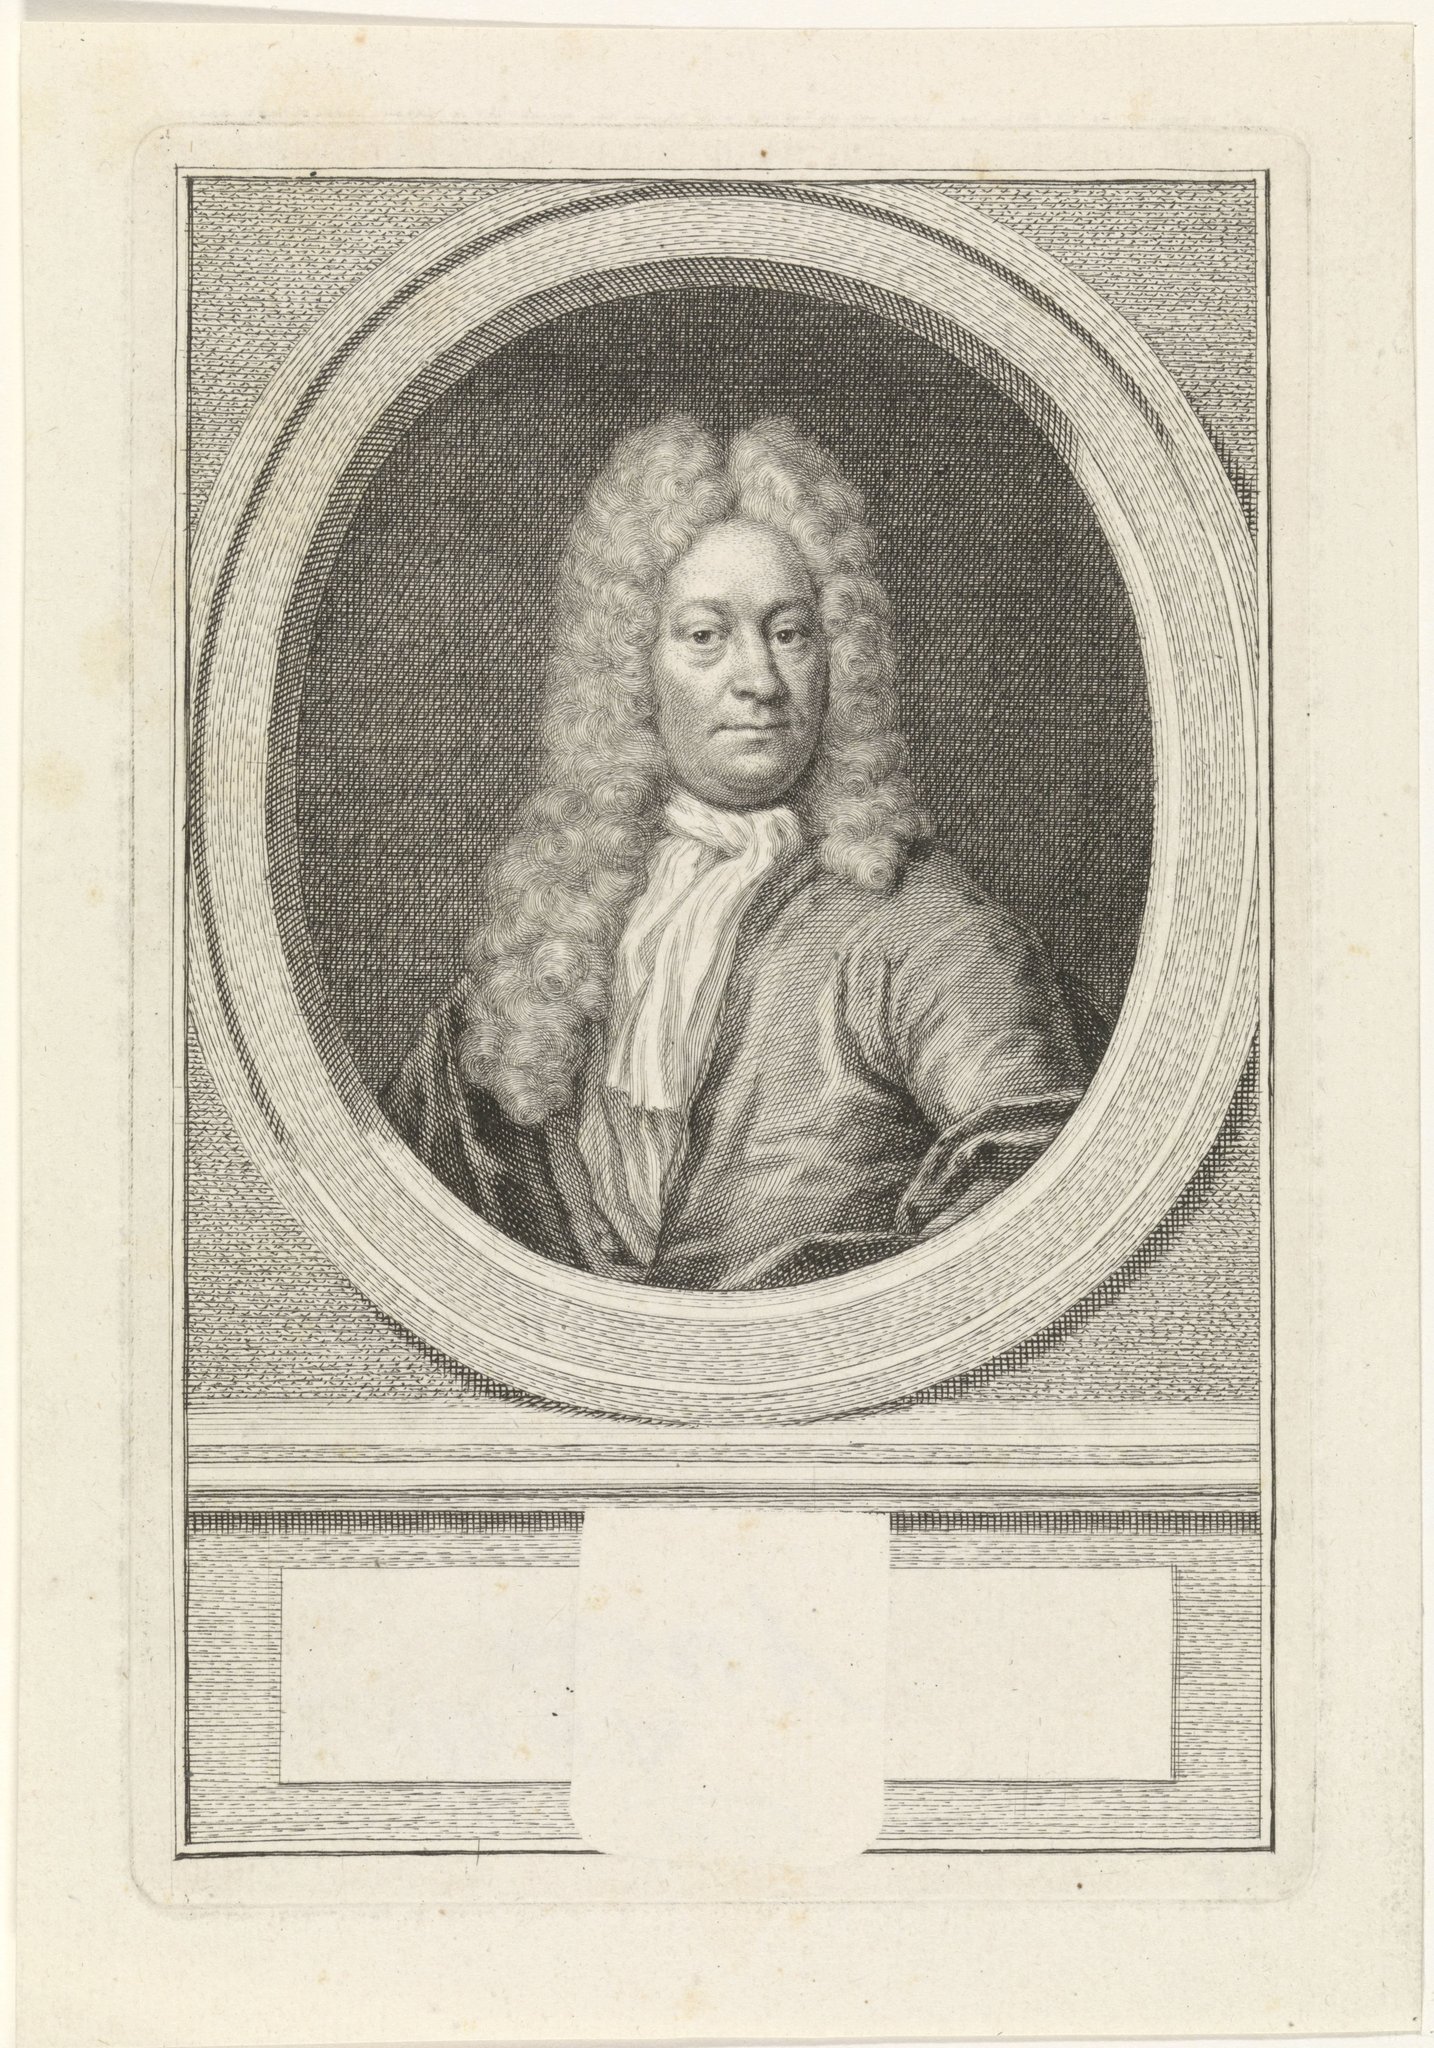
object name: print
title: Portret van Jan Sautijn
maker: jacob houbraken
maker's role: draughtsman, print maker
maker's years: 1698-1780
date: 1749-1780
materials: paper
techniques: engraving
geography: amsterdam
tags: mayor, historical persons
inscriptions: collector's mark: Lugt 2228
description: Latere staat van deze prent is oorspronkelijk bedoeld als aanvulling op Jan Wagenaars ‘Vaderlandsche historie’* en was zo vanaf 1796 verkrijgbaar bij Johannes Allart te Amsterdam. Voor de advertentie waarin Allart de 60 portretten en 7 platen, allen gegraveerd door Houbraken, ter aanvulling op Wagenaars ‘Vaderlandsche historie’ aanbiedt, zie RP-P-OB-77.766. *Van dit werk zijn in de achttiende eeuw meerdere uitgaves verschenen, zoals: Wagenaar, Jan. Vaderlandsche historie, vervattende de geschiedenissen der Vereenigde Nederlanden (…). 21 delen. Amsterdam: Isaak Tirion, 1749-1759. Wagenaar, Jan. Vaderlandsche historie, vervattende de geschiedenissen der nu Vereenigde Nederlanden (…). 21 delen. Amsterdam: weduwe Isaak Tirion, 1770. Wagenaar, Jan. Vaderlandsche historie, vervattende de geschiedenissen der nu Vereenigde Nederlanden (…). 21 delen. Amsterdam, Leiden, Dordrecht en Harlingen: P. Schouten e.a., 1782. Wagenaar, Jan. Vaderlandsche historie, vervattende de geschiedenissen der nu Vereenigde Nederlanden (…). 21 delen. Amsterdam: Johannes Allart, 1790-1796.